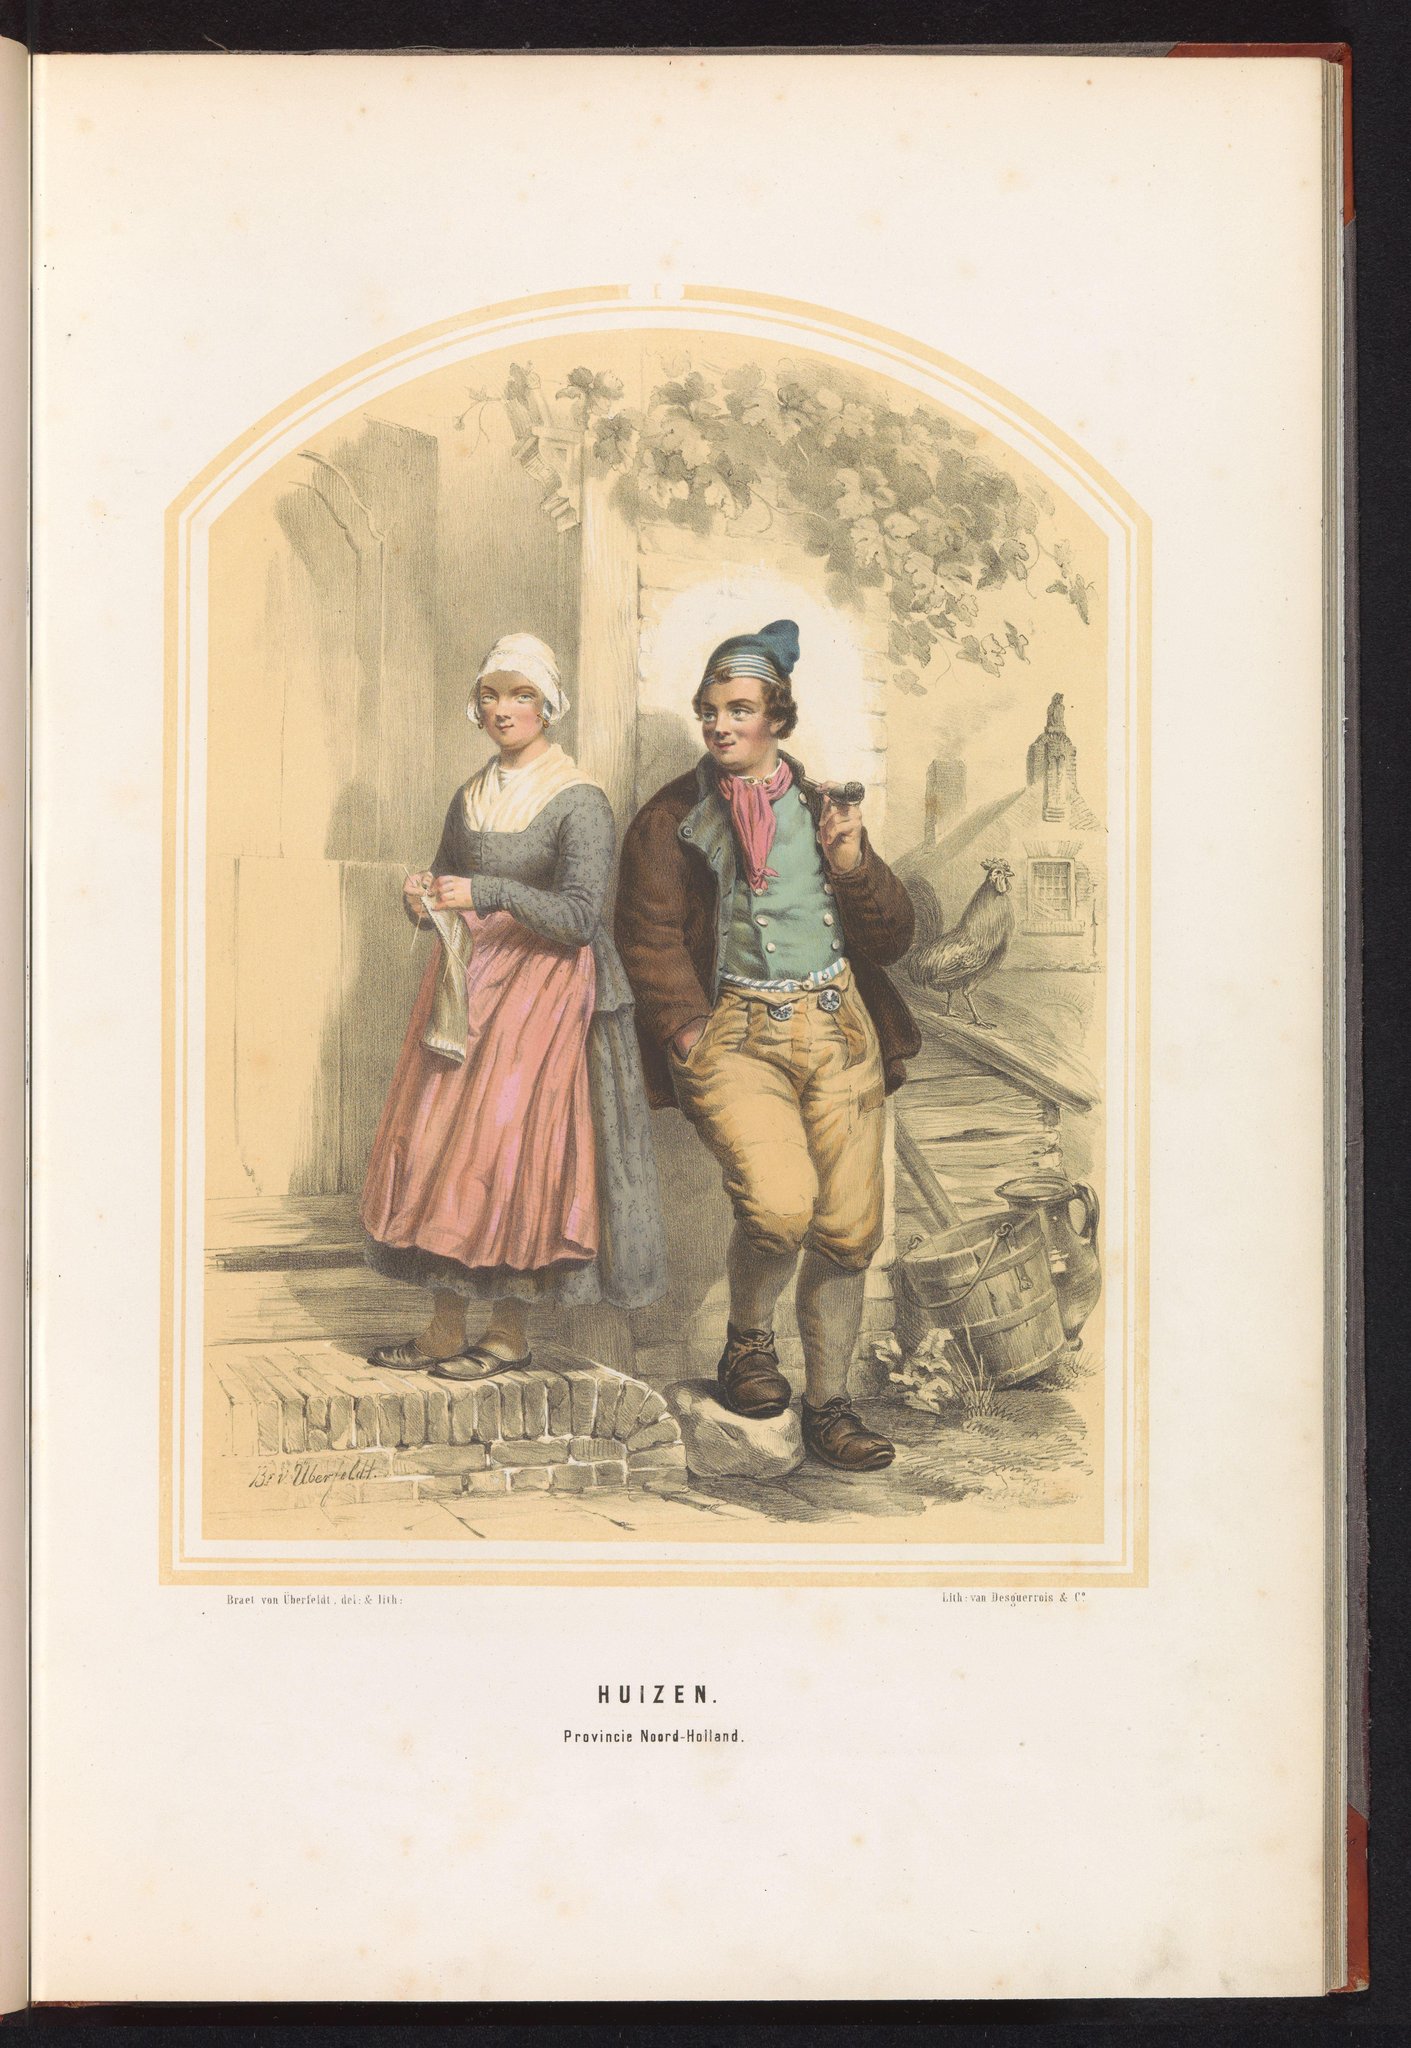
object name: costume print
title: Huizen. Provincie Noord-Holland / I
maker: jan braet von uberfeldt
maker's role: draughtsman, print maker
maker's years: 1807-1894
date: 1857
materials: paper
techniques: hand coloring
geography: amsterdam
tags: folk costume, regional costume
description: Klederdracht van de plaats Huizen in Noord-Holland. Man en vrouw bij de deur van een woning. Illustratie in een boek uit 1857 met 56 platen van Nederlandse klederdrachten.